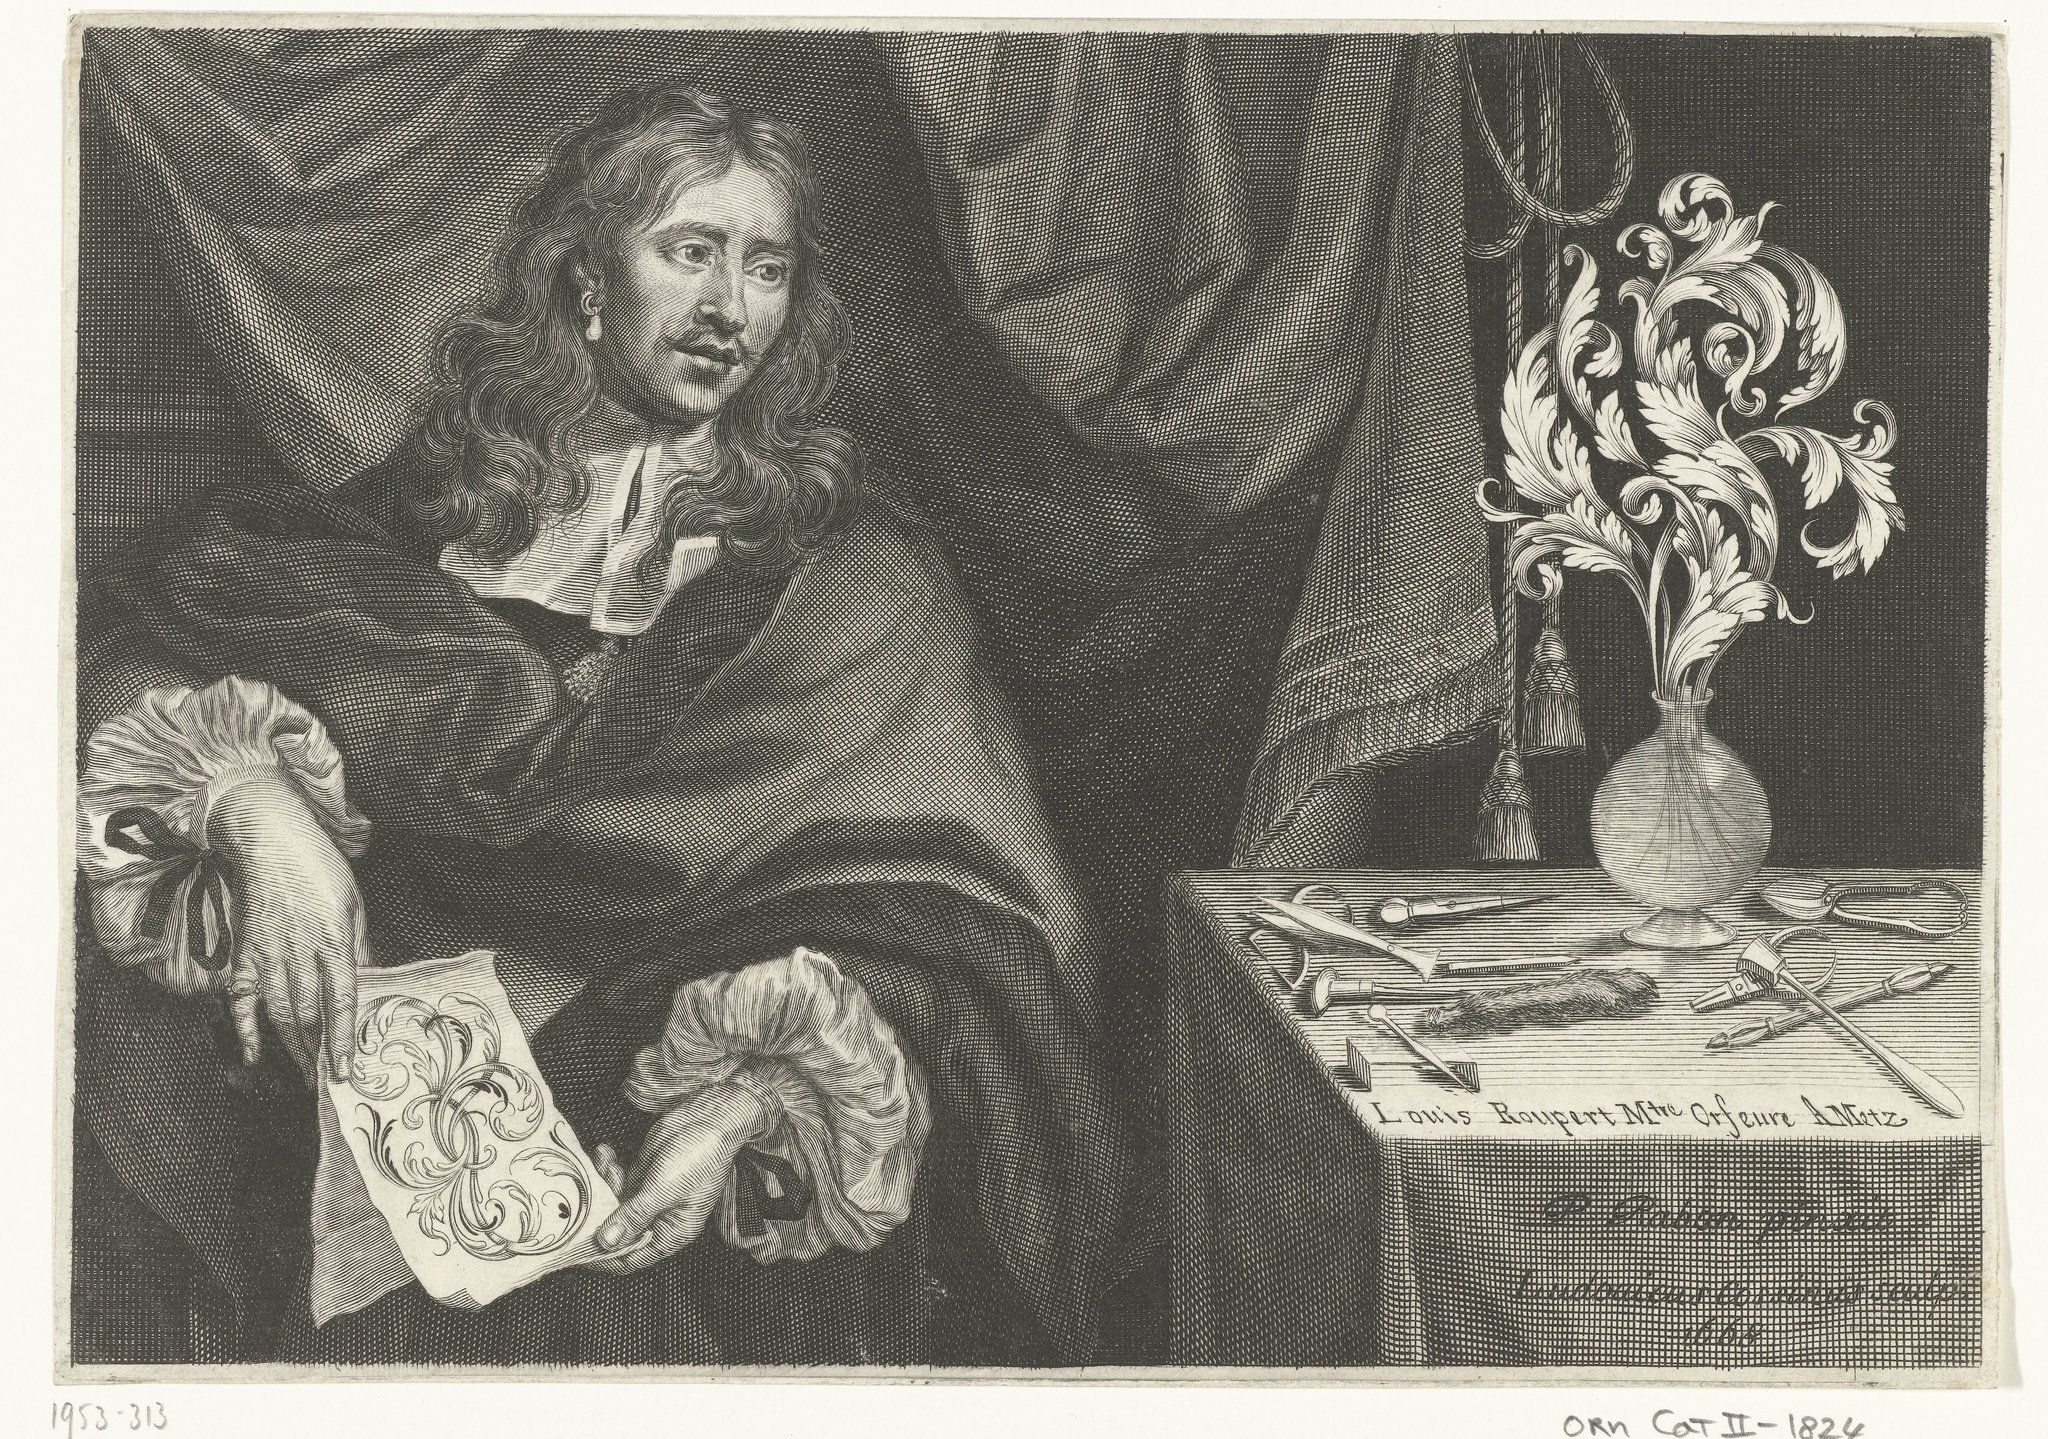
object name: titelprent, frontispice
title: Titelprent met het portret van Louis Roupert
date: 1668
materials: paper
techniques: engraving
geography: paris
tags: paris, goldsmith, louis roupert, tools, implements of craftsman (with name), ear-rings (+ men's clothes), historical persons, jeweller, goldsmith, silversmith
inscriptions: inscription: ‘Louis Roupert Mtre Orfeure A Metz./ P. Rabon pinxit/ Ludouicus Coruinus sculp./ 1668.’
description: Portret van de goud- en zilversmid Louis Roupert, staand naast een tafel waarop de verschillend gereedschap van de goud- en zilversmid en een vaas met bladranken. Roupert draagt een oorbel in zijn rechteroor en houdt een ontwerptekening in zijn handen. Achter hem een draperie.